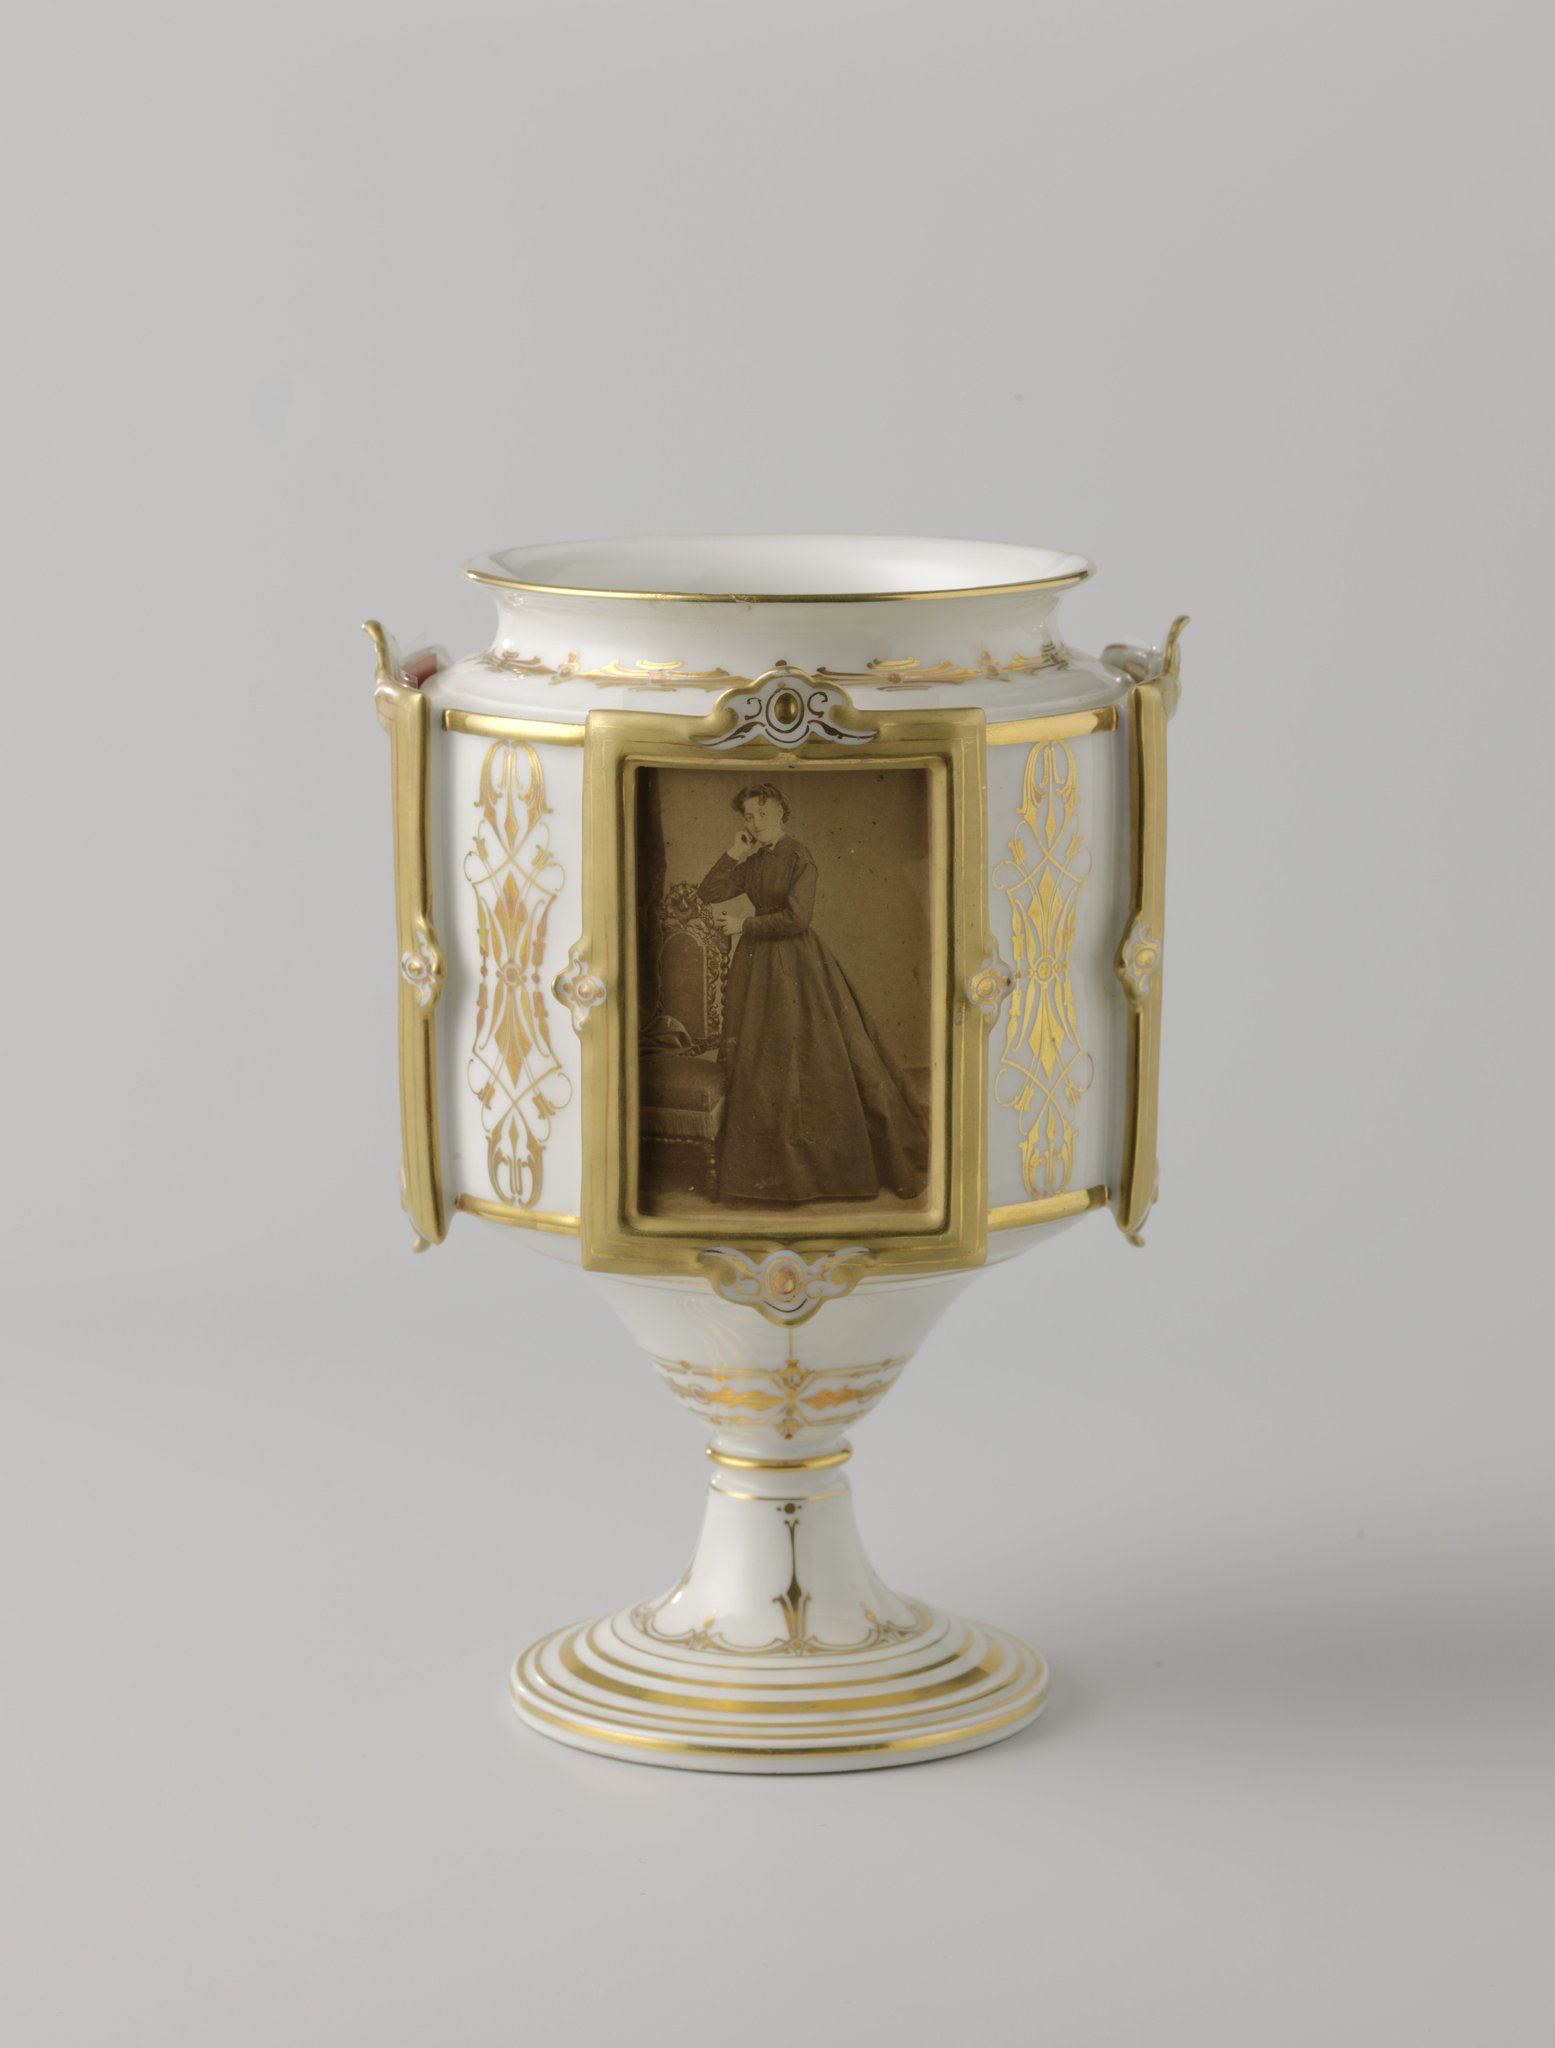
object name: vase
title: Vaas met vier carte-de-visite-portretten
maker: Anonymous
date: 1400-1950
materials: porcelain